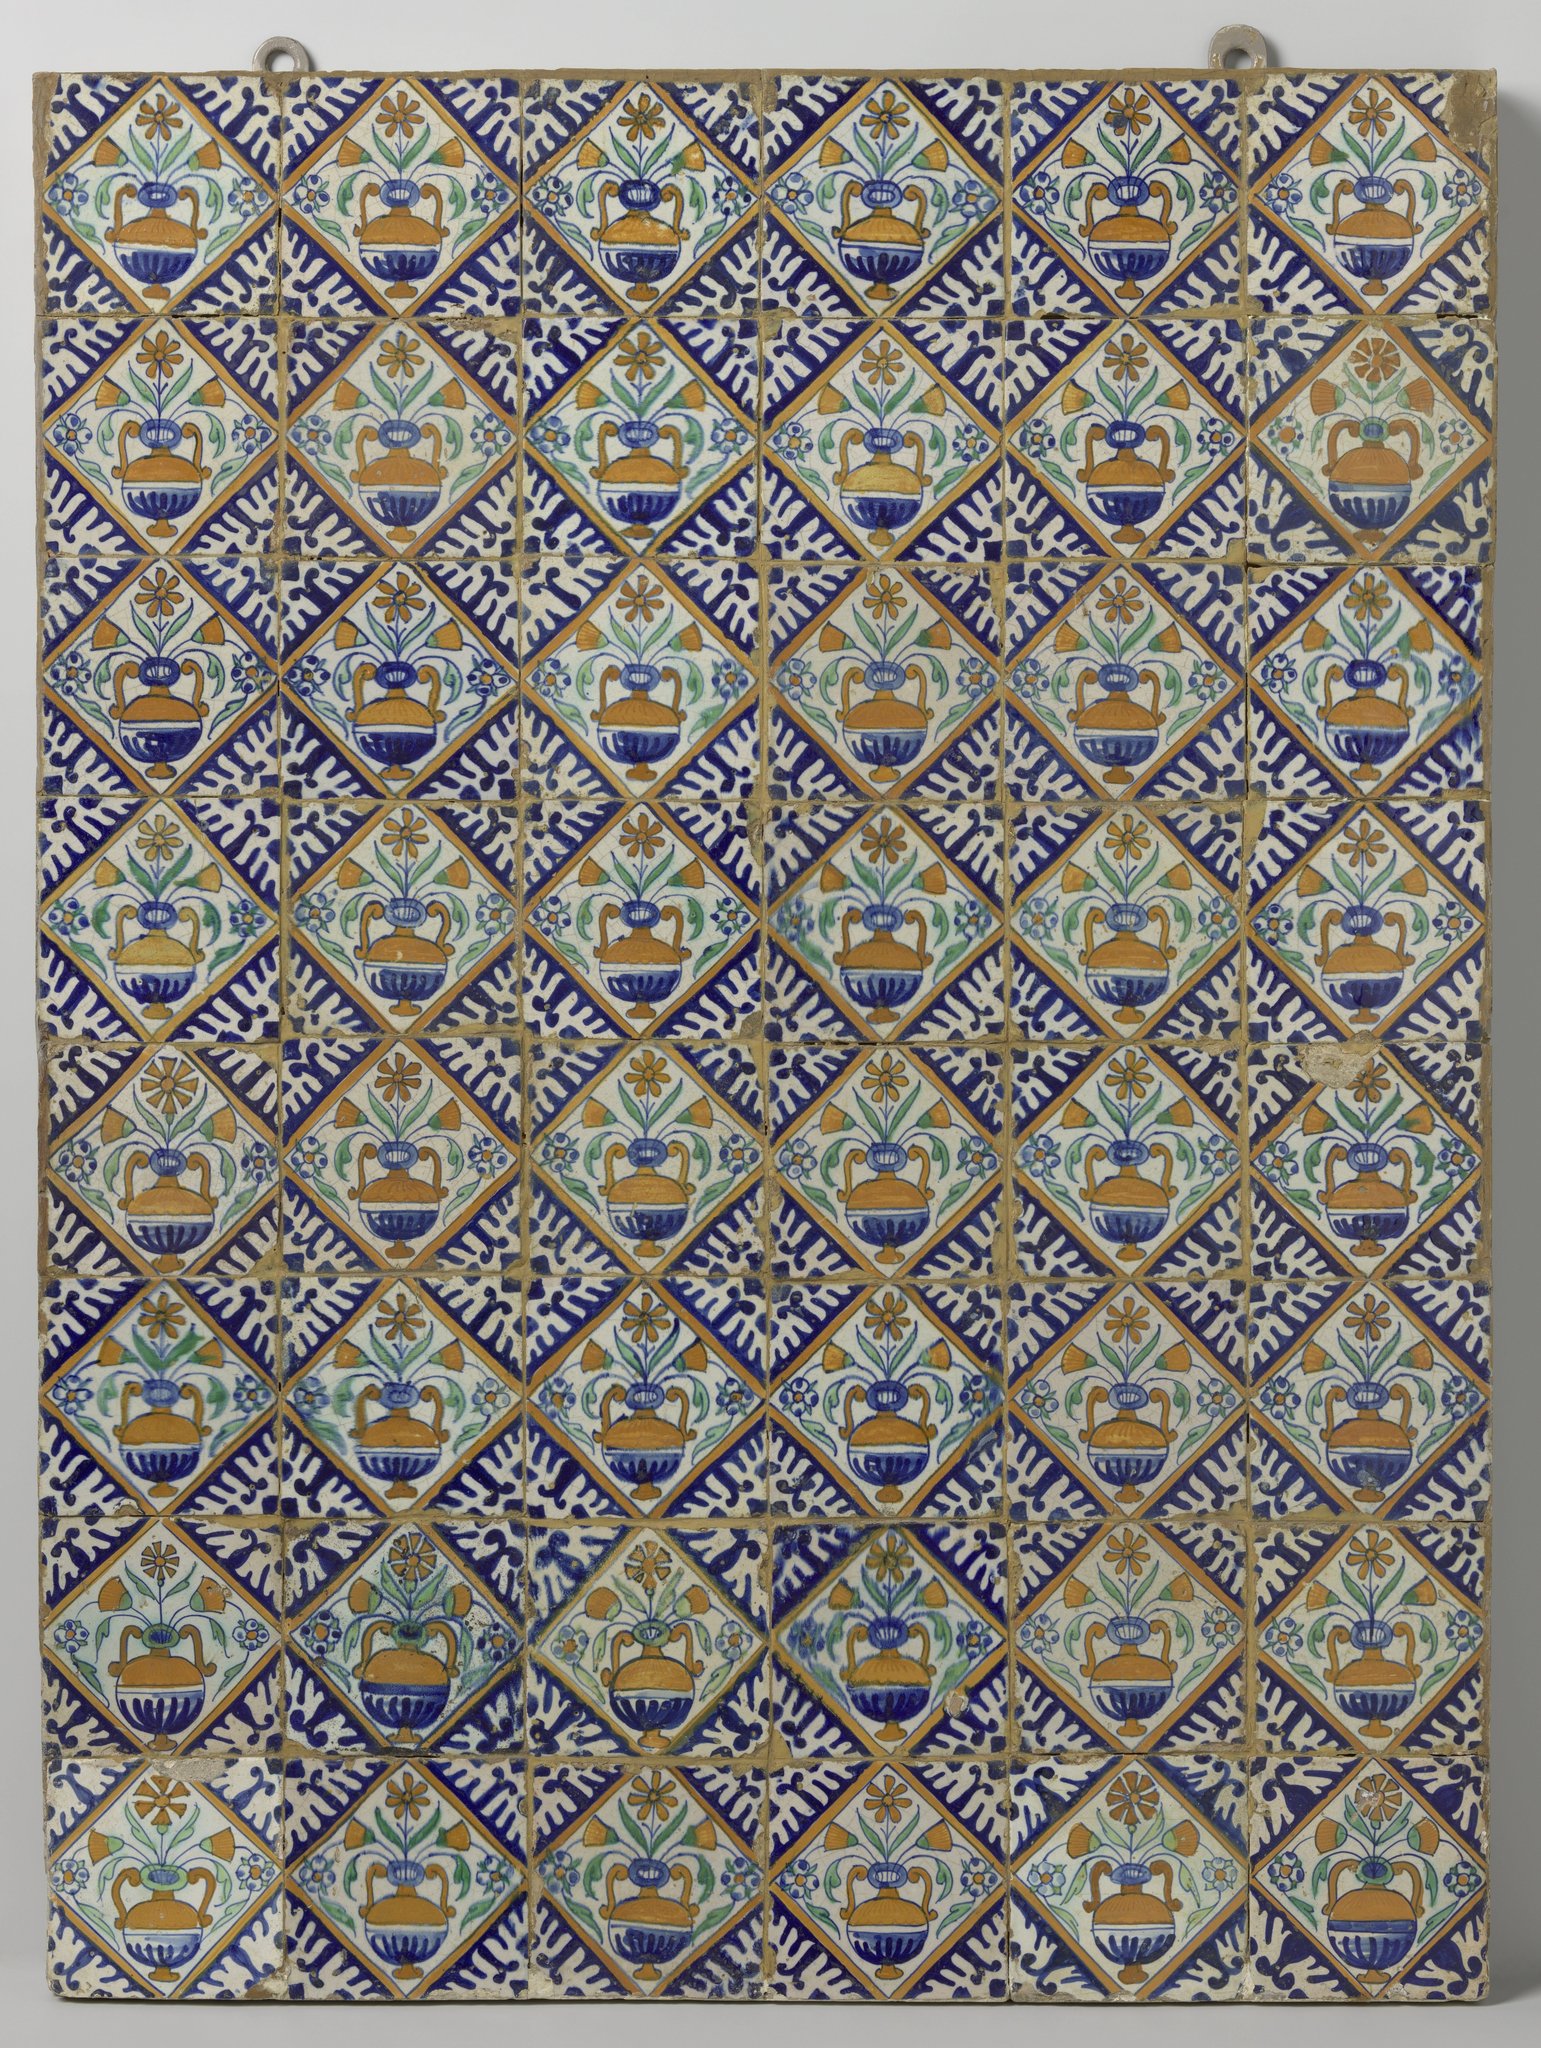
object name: tegelveld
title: Veld van achtenveertig tegels met bloempotten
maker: Anonymous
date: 1580-1625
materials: earthenware, glaze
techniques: maiolica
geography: netherlands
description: Veld van achtenveertig tegels (8 x 6) elk met een veelkleurige (blauw, oranje, groen en geel) bloempot binnen een kwadraat omlijsting. In de hoeken, ornament in vultechniek.